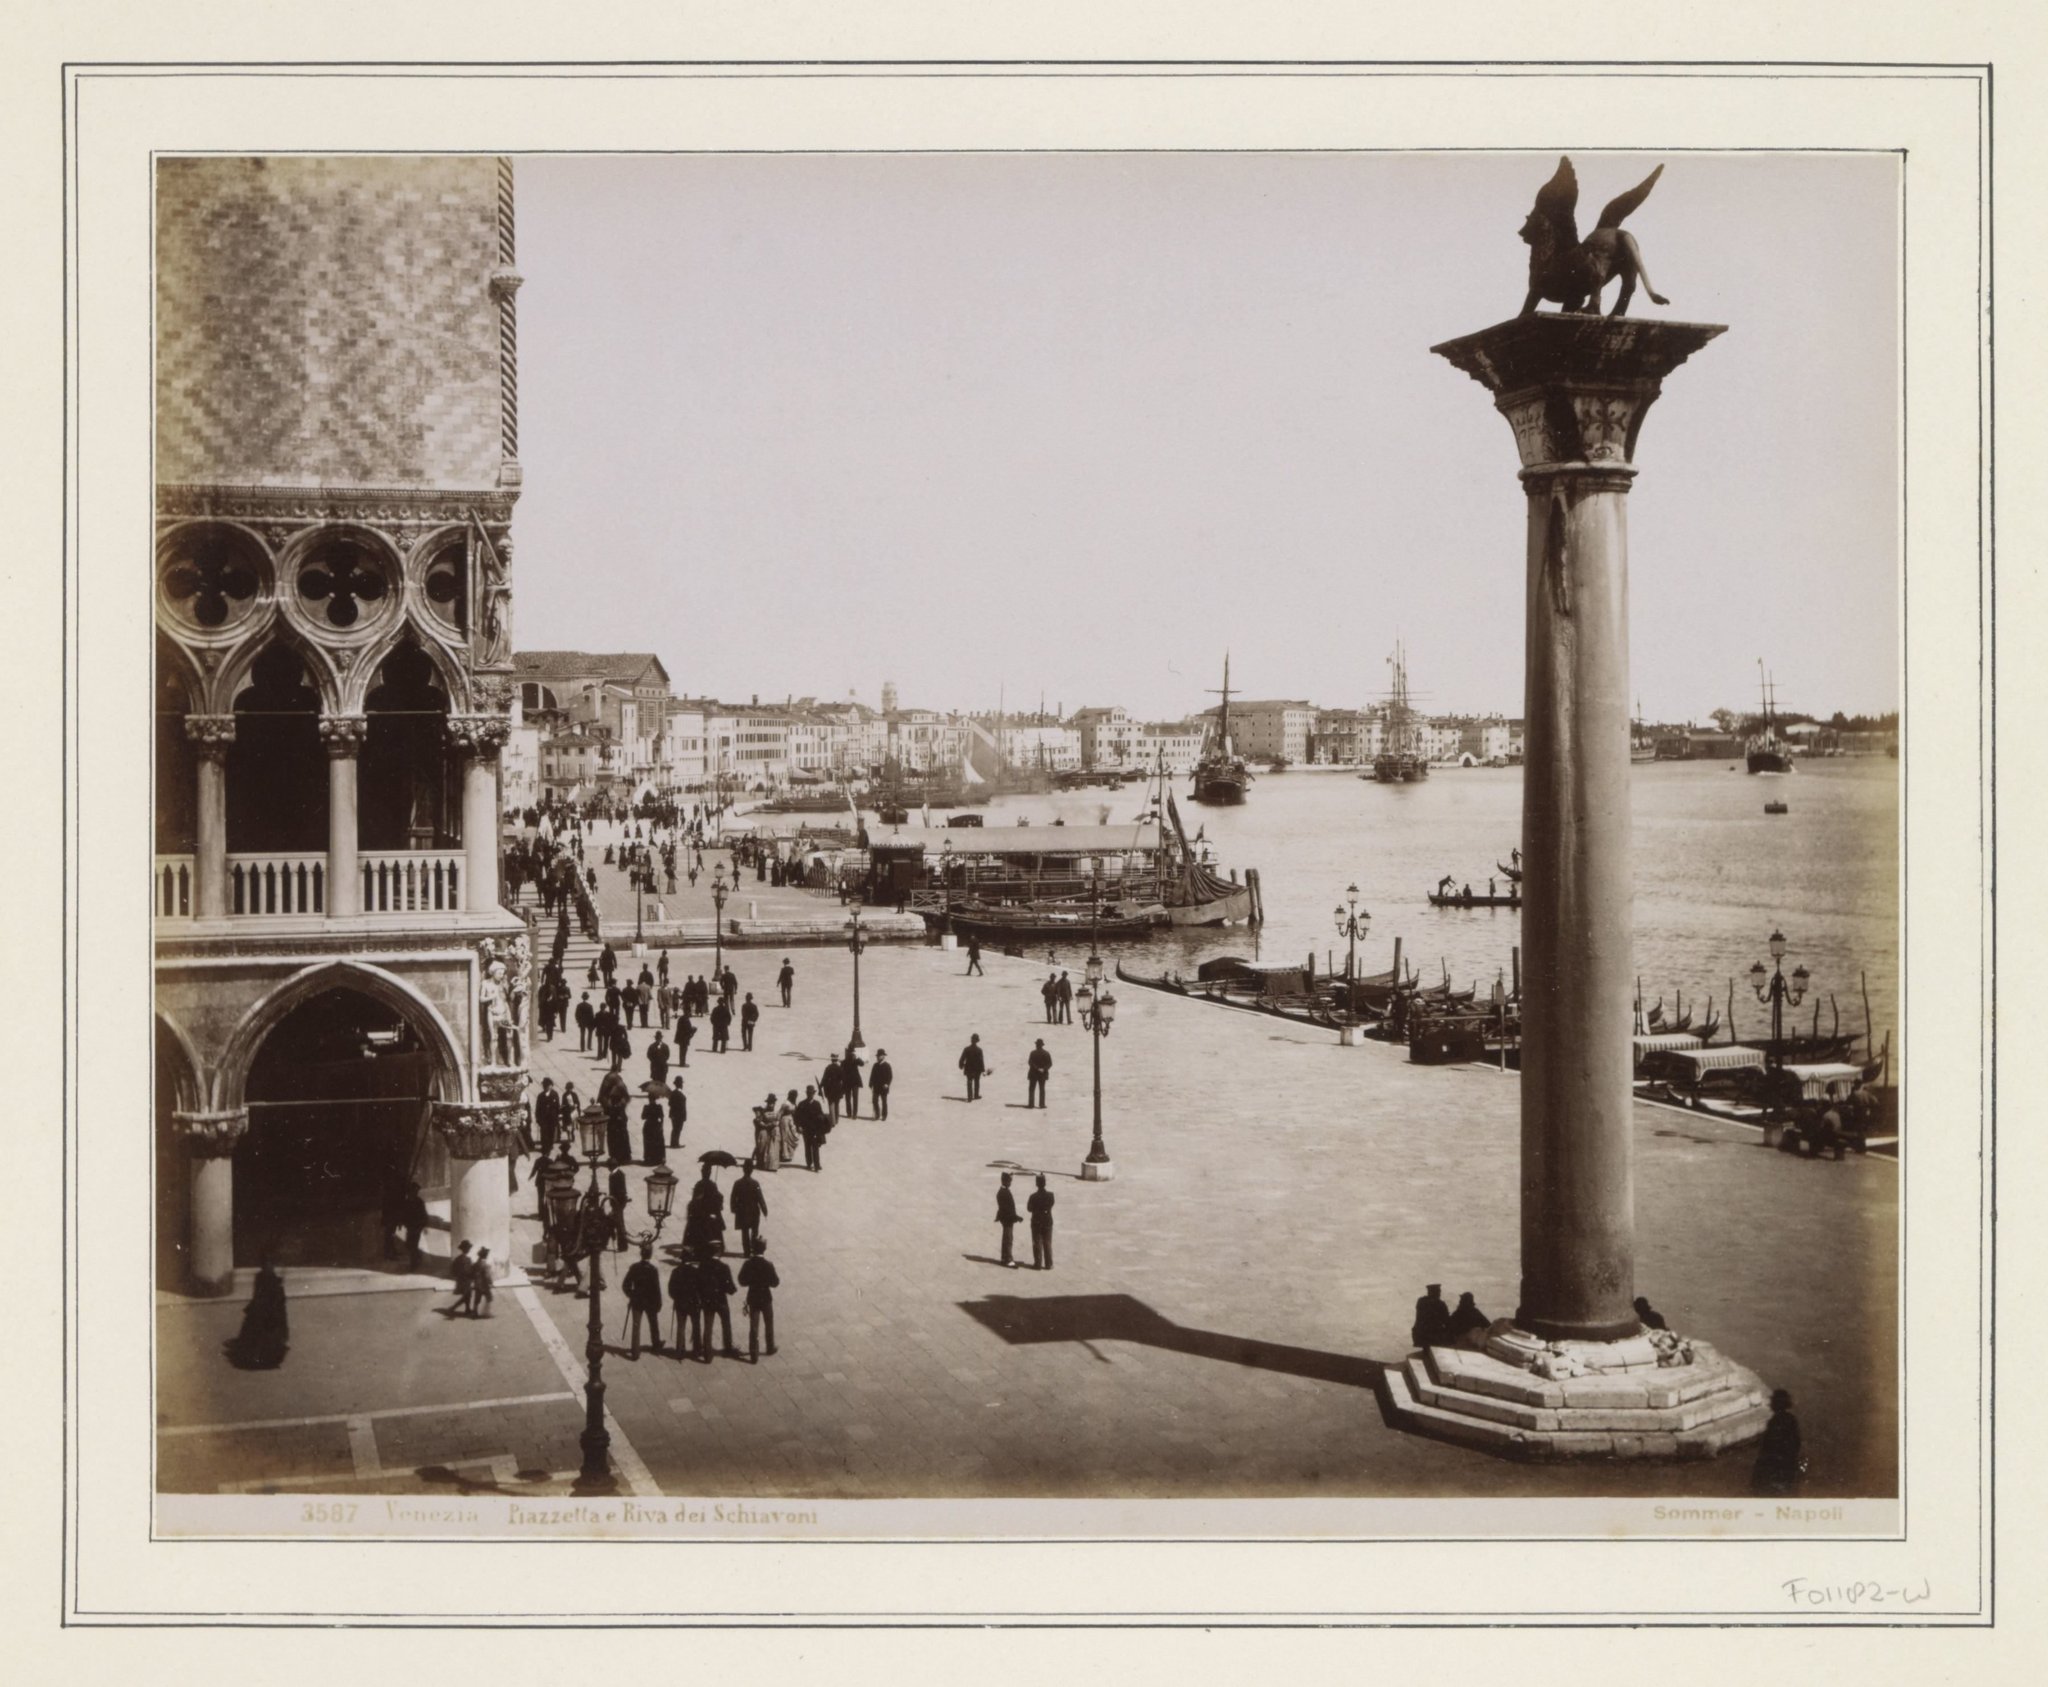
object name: photograph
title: Gezicht op de Riva degli Schiavoni met op de voorgrond een pilaar met de leeuw van Venetië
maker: giorgio sommer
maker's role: fotograaf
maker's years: 1834-1914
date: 1860-1890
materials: paper, photographic support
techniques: albumen print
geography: venice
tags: column, pillar ~ architecture, palace, piece of sculpture, reproduction of a piece of sculpture, square, place, circus, etc. (+ city(-scape) with figures, staffage), venice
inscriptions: negative number: ‘3587’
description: Onderdeel van Reisalbum met foto's van bezienswaardigheden in Italië en aan de Franse Rivièra (deel II).